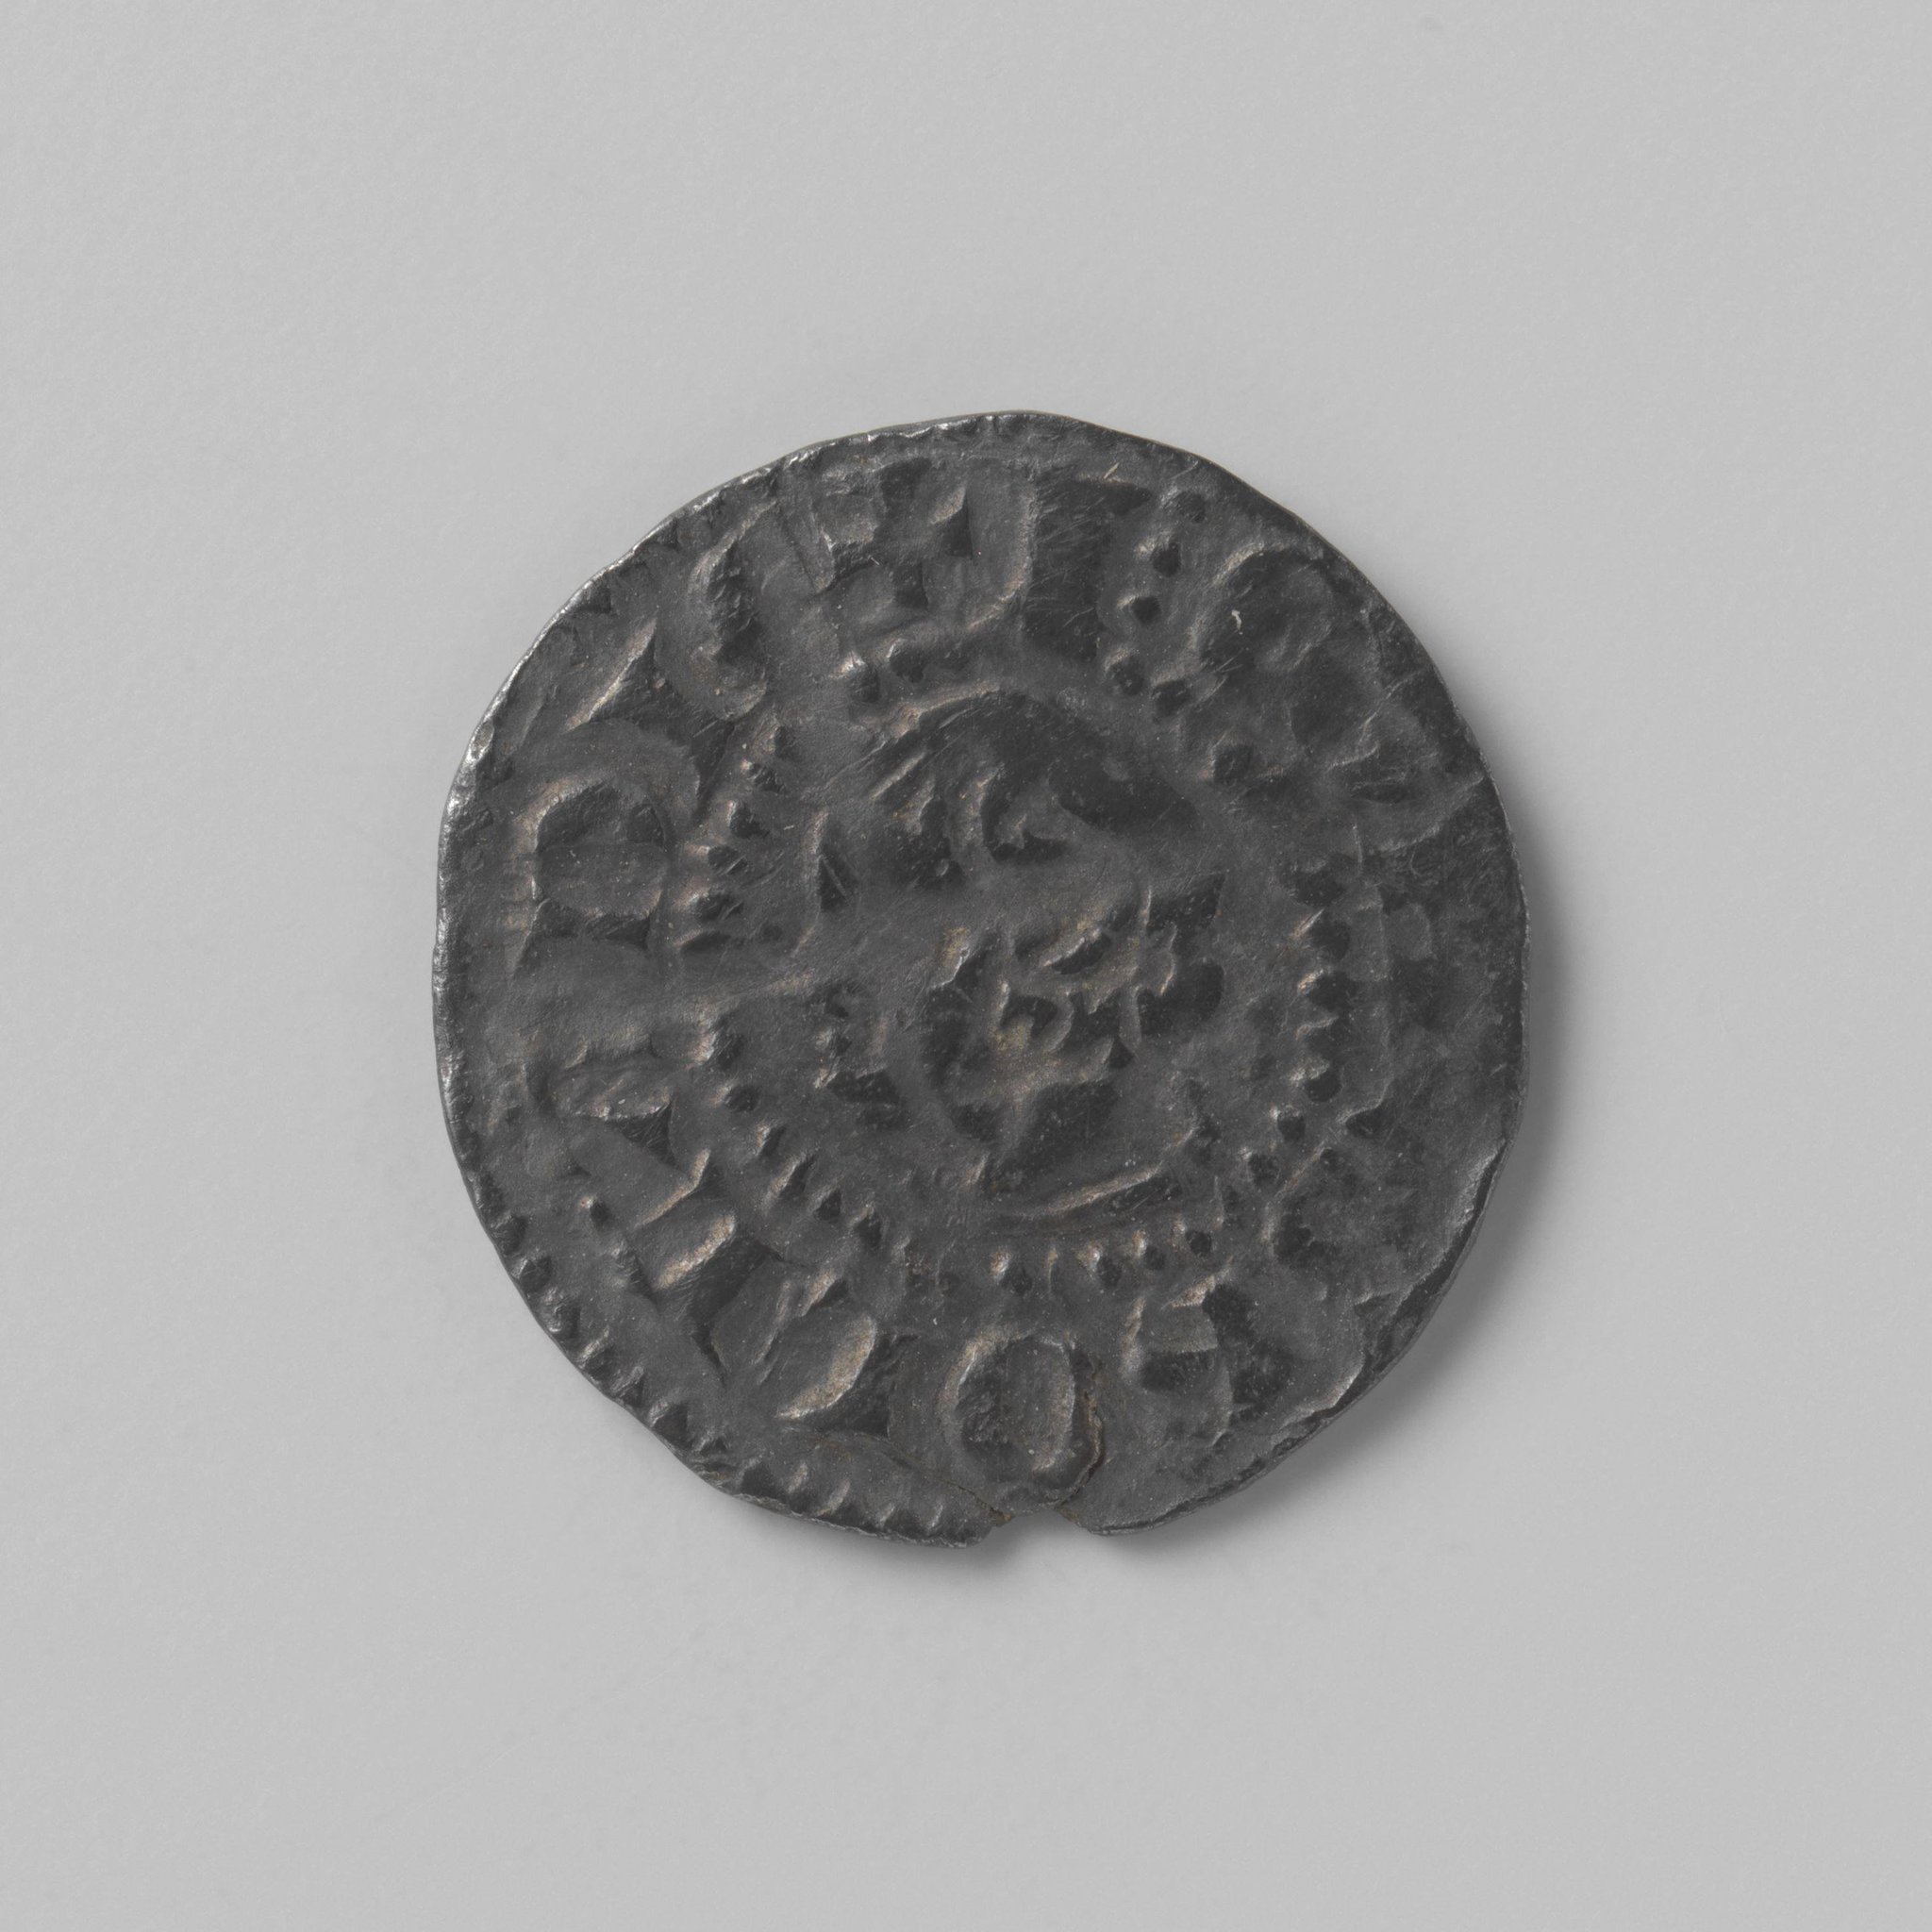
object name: penny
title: Hollandse penning van Jan I, 1296-1299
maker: jan i (graaf van holland)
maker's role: earl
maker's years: 1284-1299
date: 1298-1299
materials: silver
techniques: striking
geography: dordrecht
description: Zilveren munt. Voorzijde: hoofd naar links. Keerzijde: lang gevoet kruis.